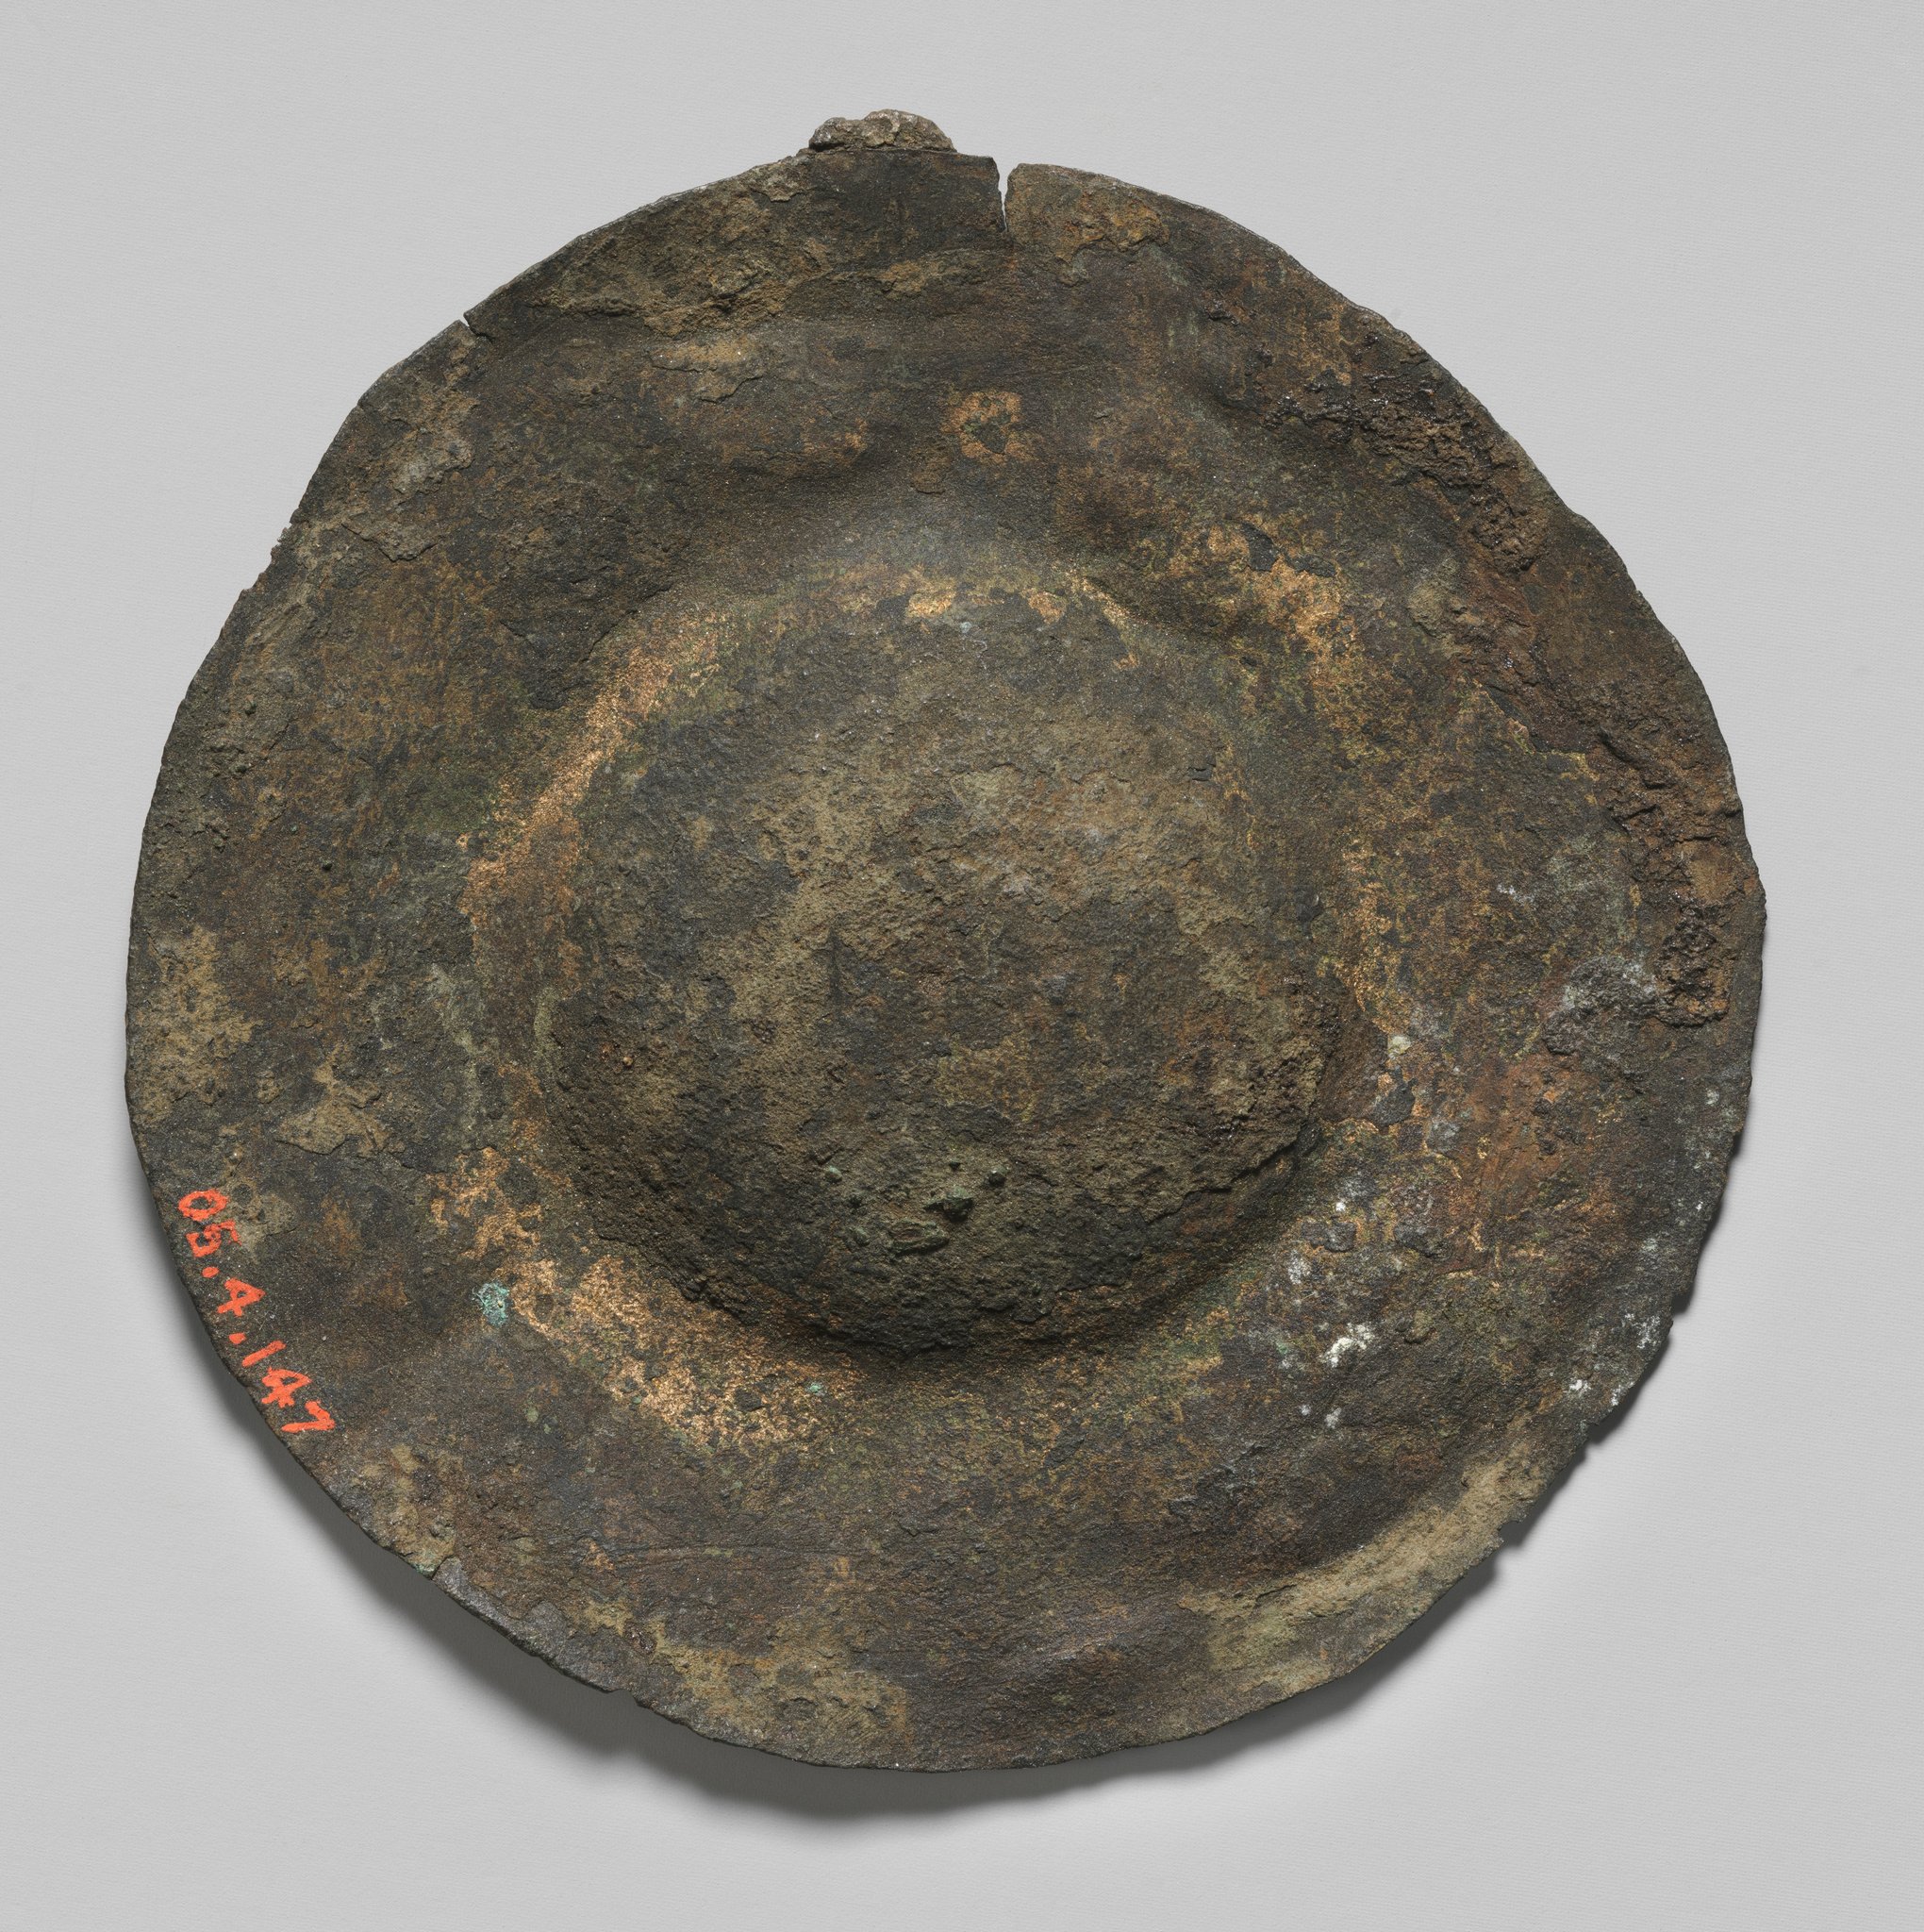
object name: disk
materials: copper alloy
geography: egypt